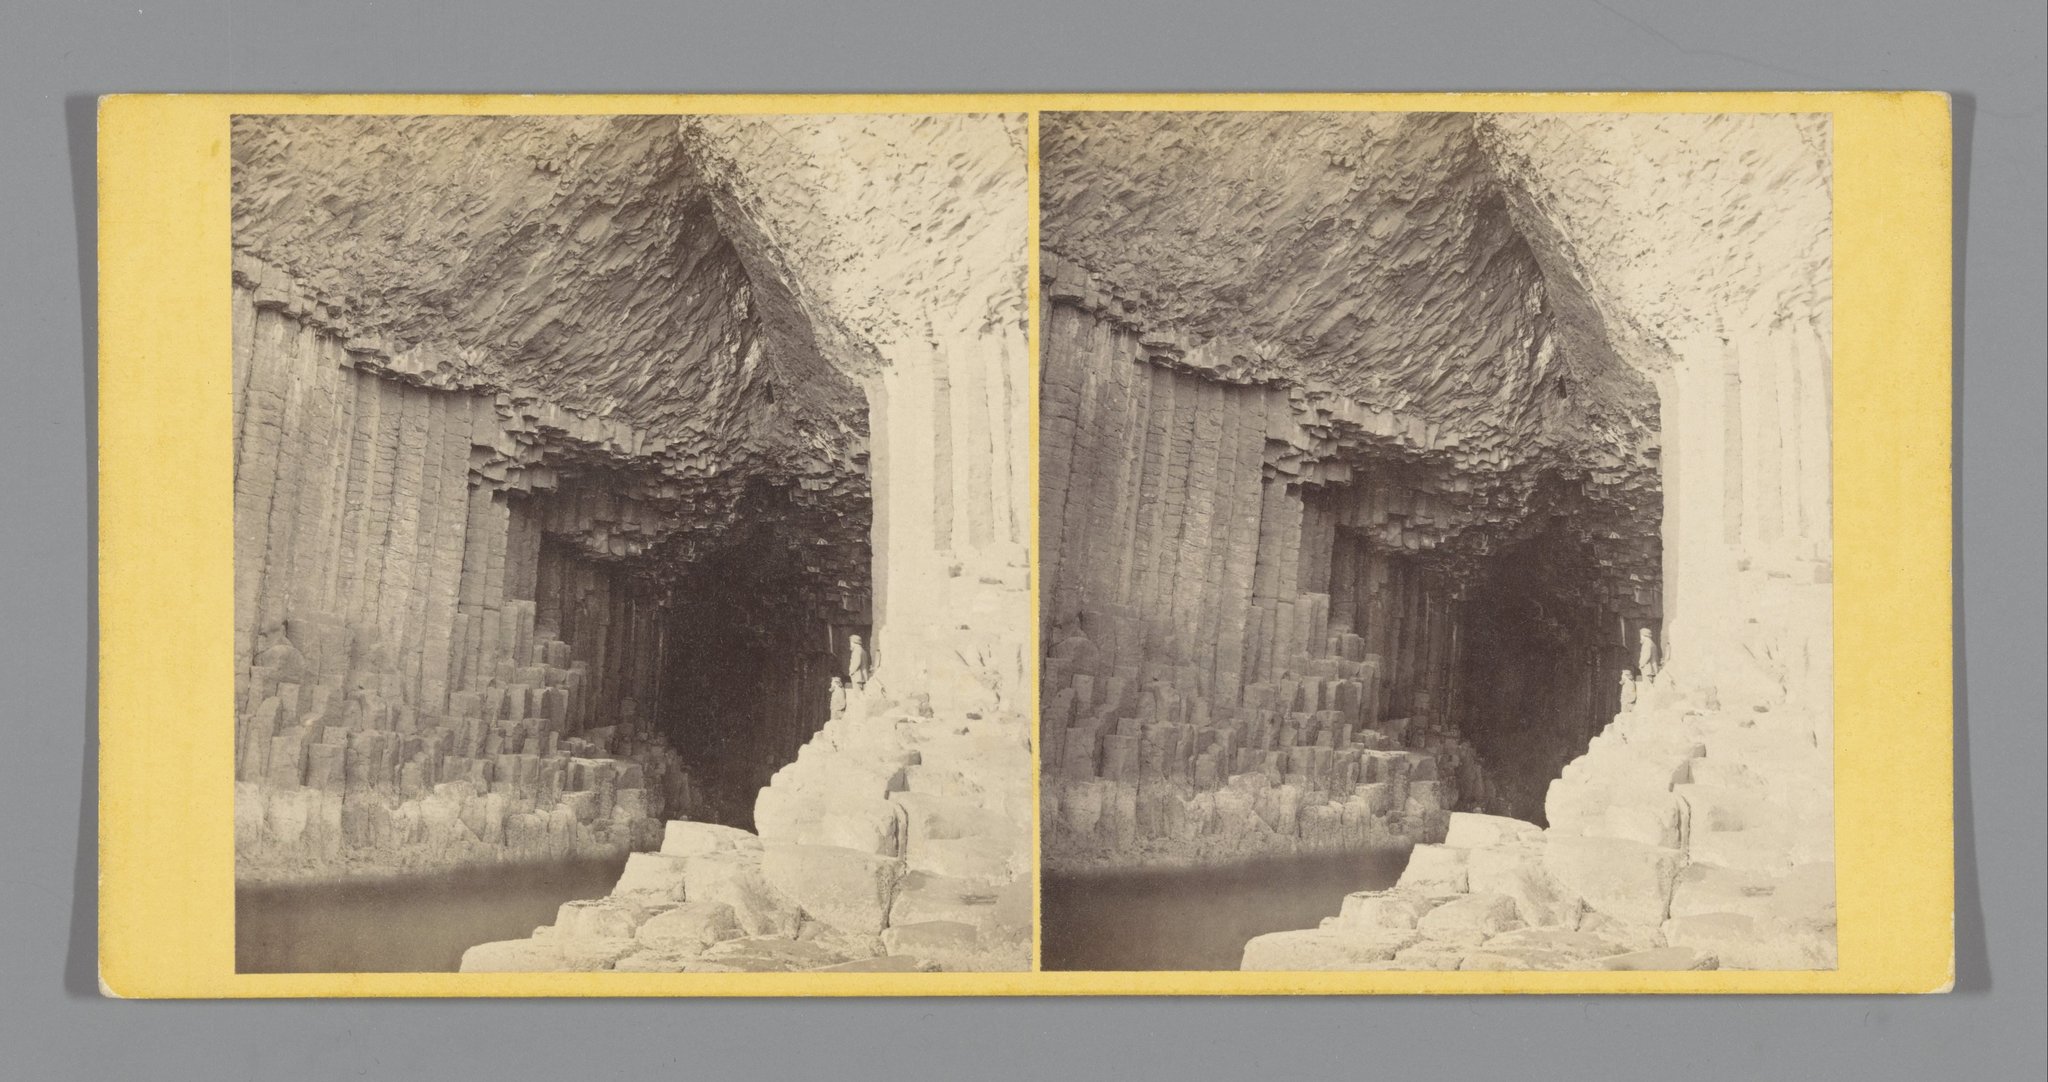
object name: stereograph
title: Gezicht op Fingal's Cave op Staffa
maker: george washington wilson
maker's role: publisher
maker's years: 1823-1893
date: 1850-1880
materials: cardboard, photographic support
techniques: albumen print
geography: staffa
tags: island, cave, grotto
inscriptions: name: ‘G. W. Wilson, Photor. Aberdeen.’, number: ‘No. 145’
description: De objecten RP-F-F04782 en RP-F-F04814 zijn vermoedelijk tijdens dezelfde fotografeersessie gemaakt.